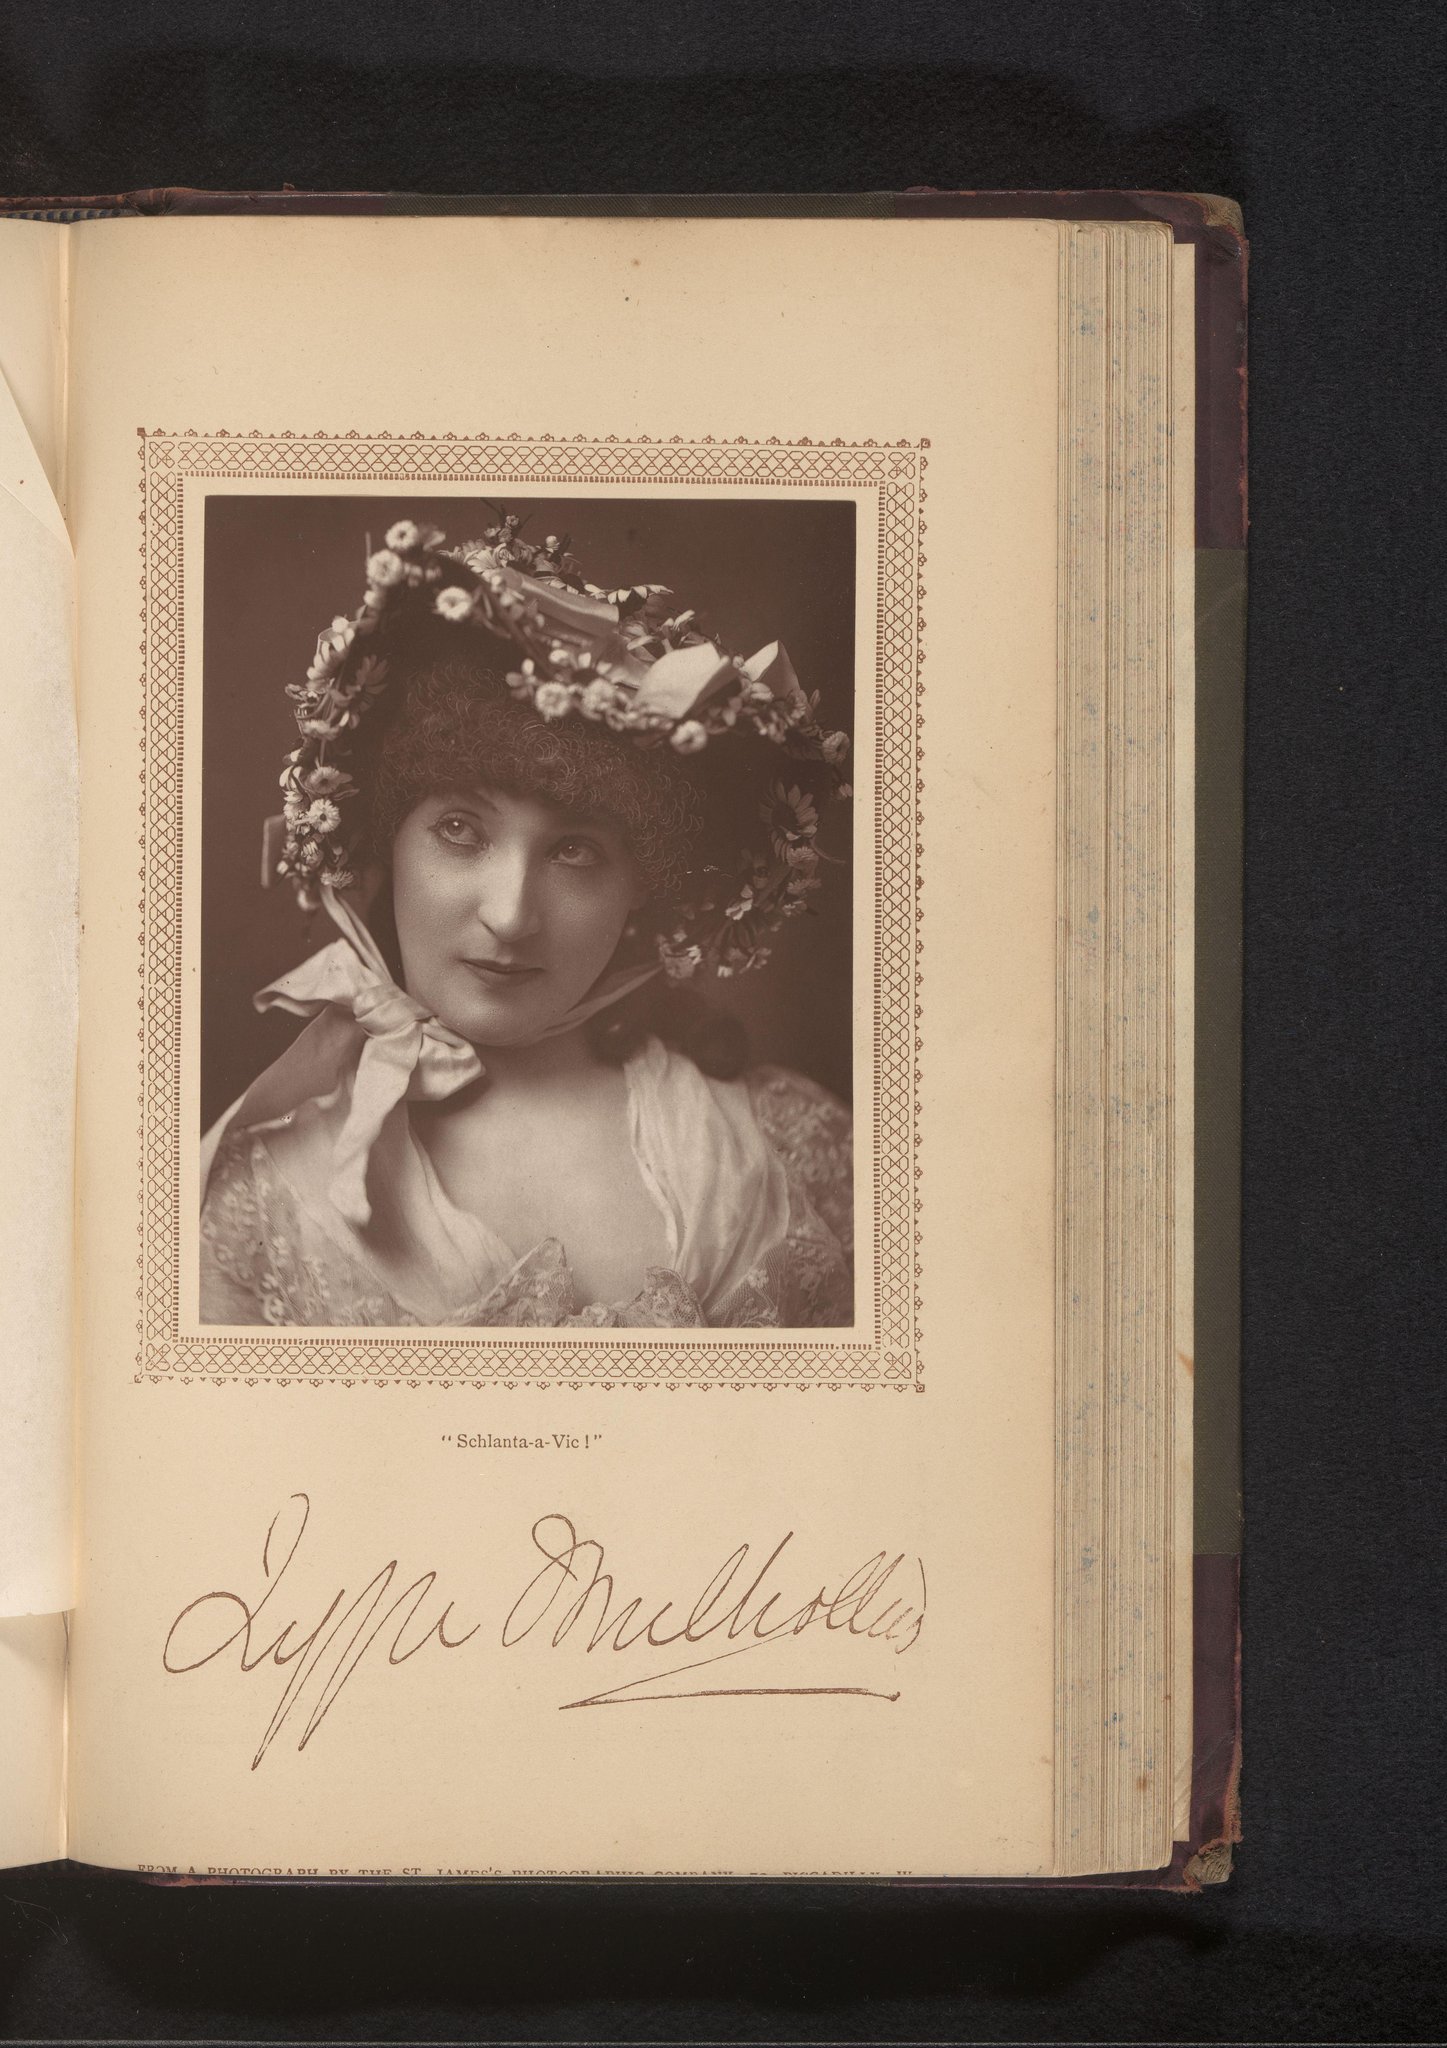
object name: photomechanical print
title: Portret van een onbekende vrouw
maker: Anonymous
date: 1879-1884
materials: paper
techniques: woodburytype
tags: adult man, historical persons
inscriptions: signature: ‘[...]’, inscription: ‘'Schlanta-a-Vic!'’